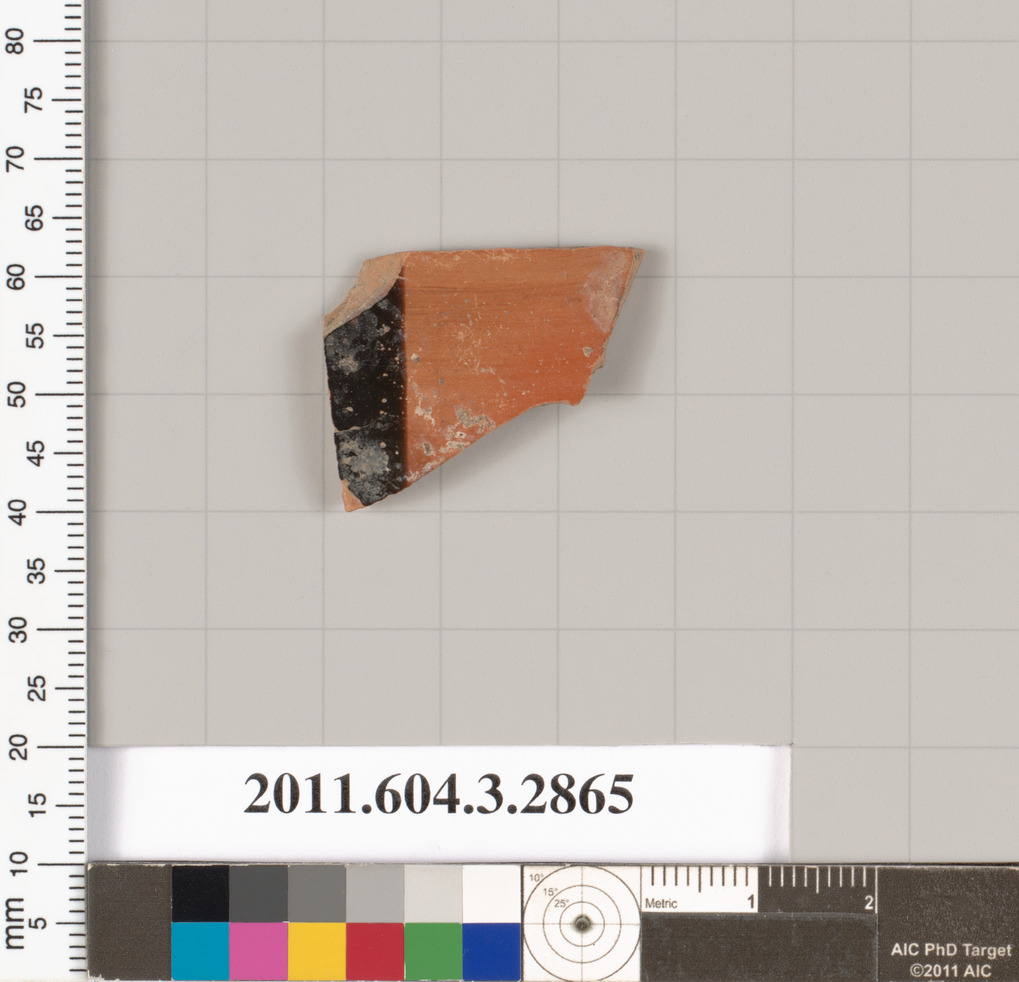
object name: undetermined closed shape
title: Terracotta fragment of a closed shape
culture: greek, attic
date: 600-401 BCE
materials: terracotta